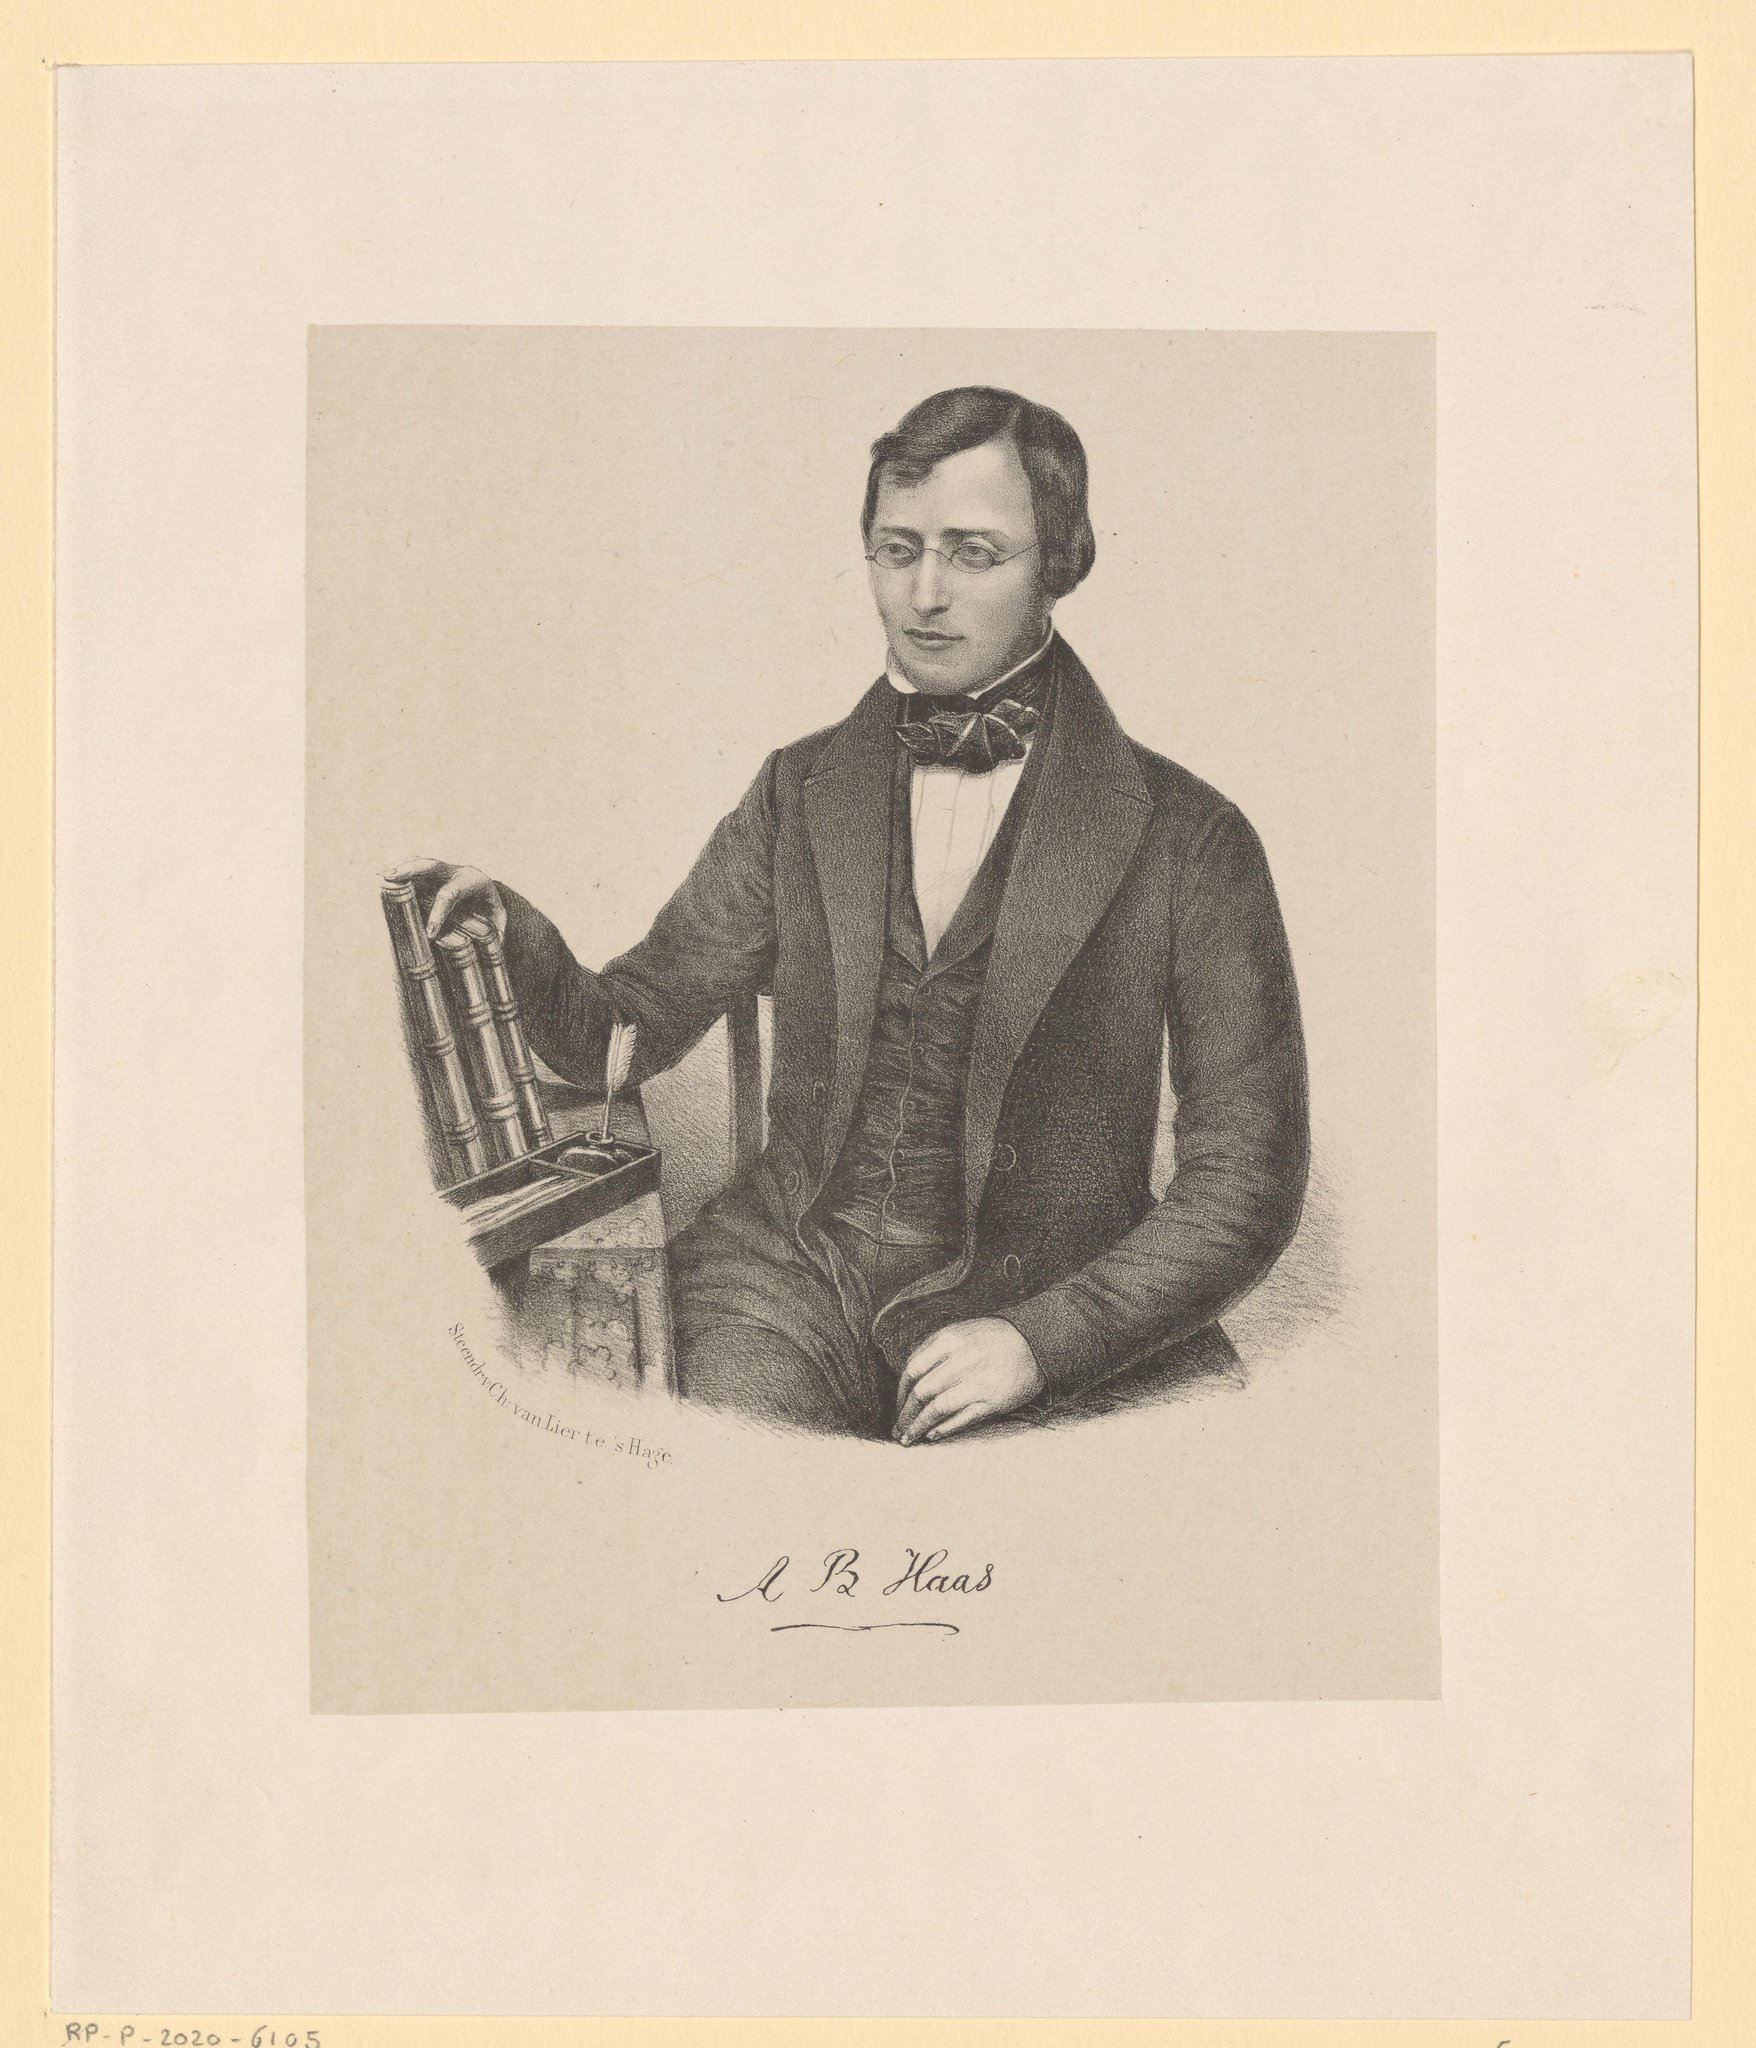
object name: print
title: Portret van A.B. Haas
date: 1847-1882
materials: paper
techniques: lithograph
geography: the hague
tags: eyeglasses, spectacles, historical persons, book